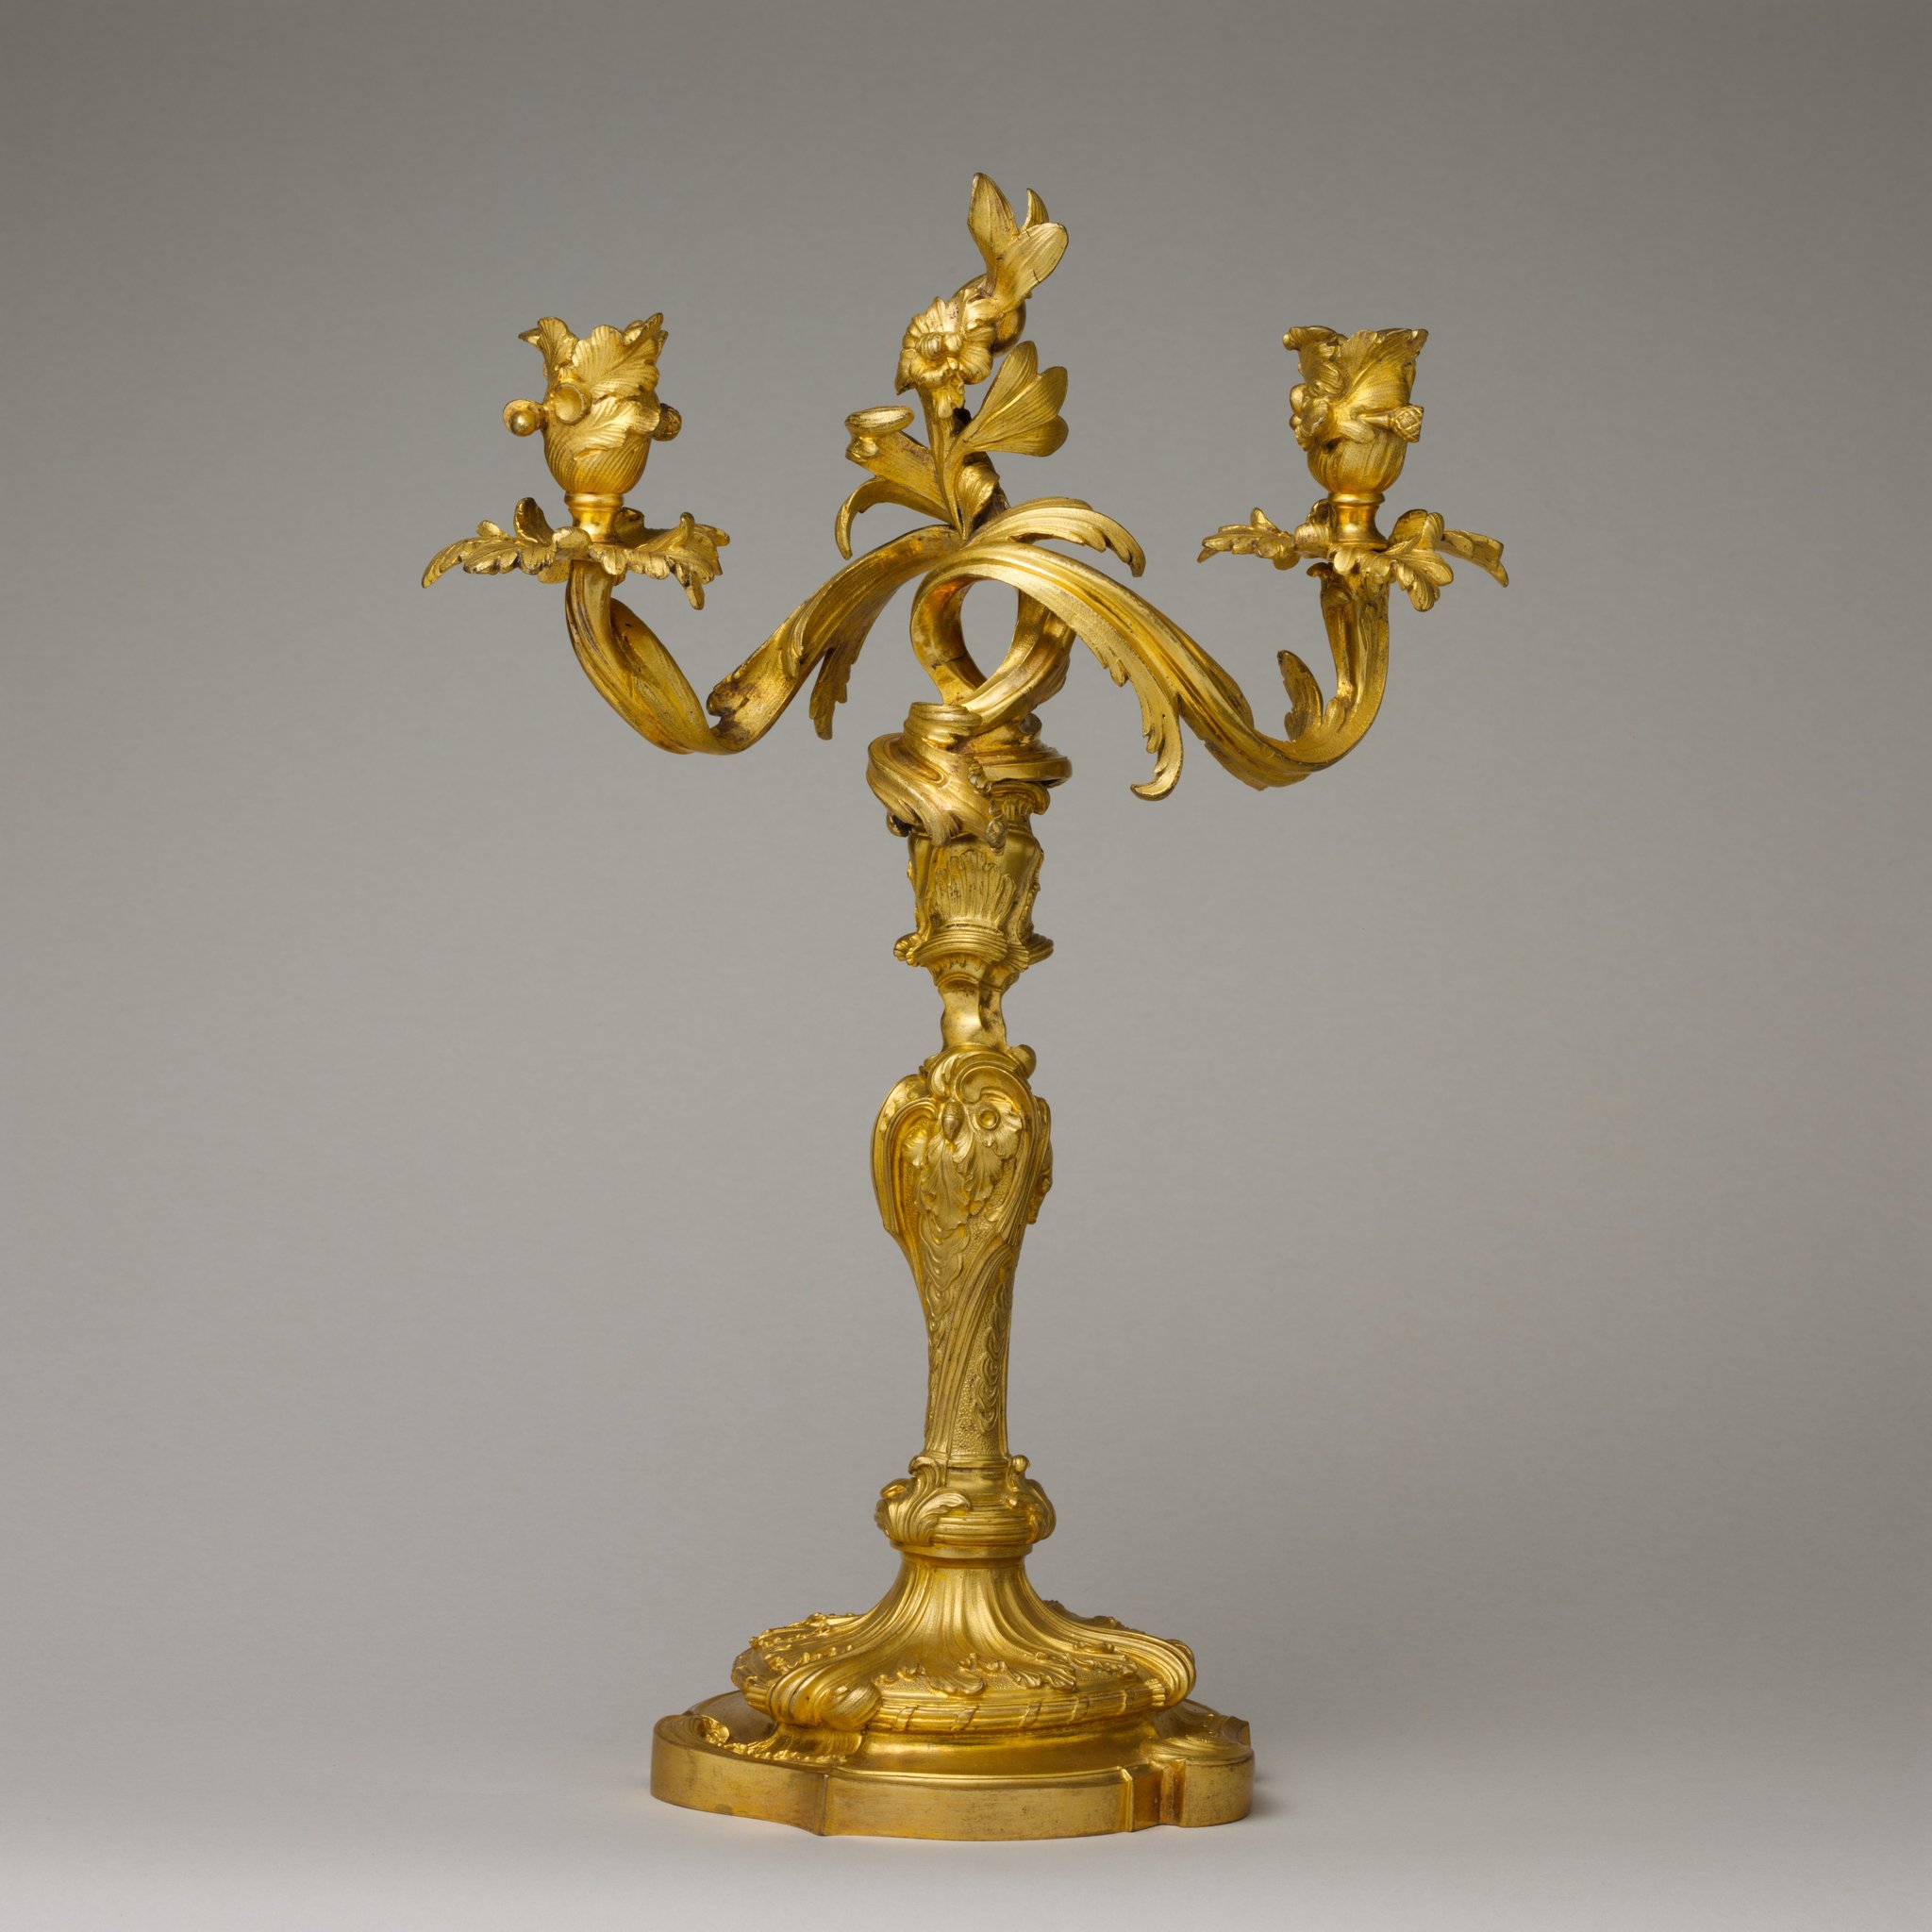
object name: candelabrum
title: Pair of two-light candelabra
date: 1745-1755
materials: gilt bronze